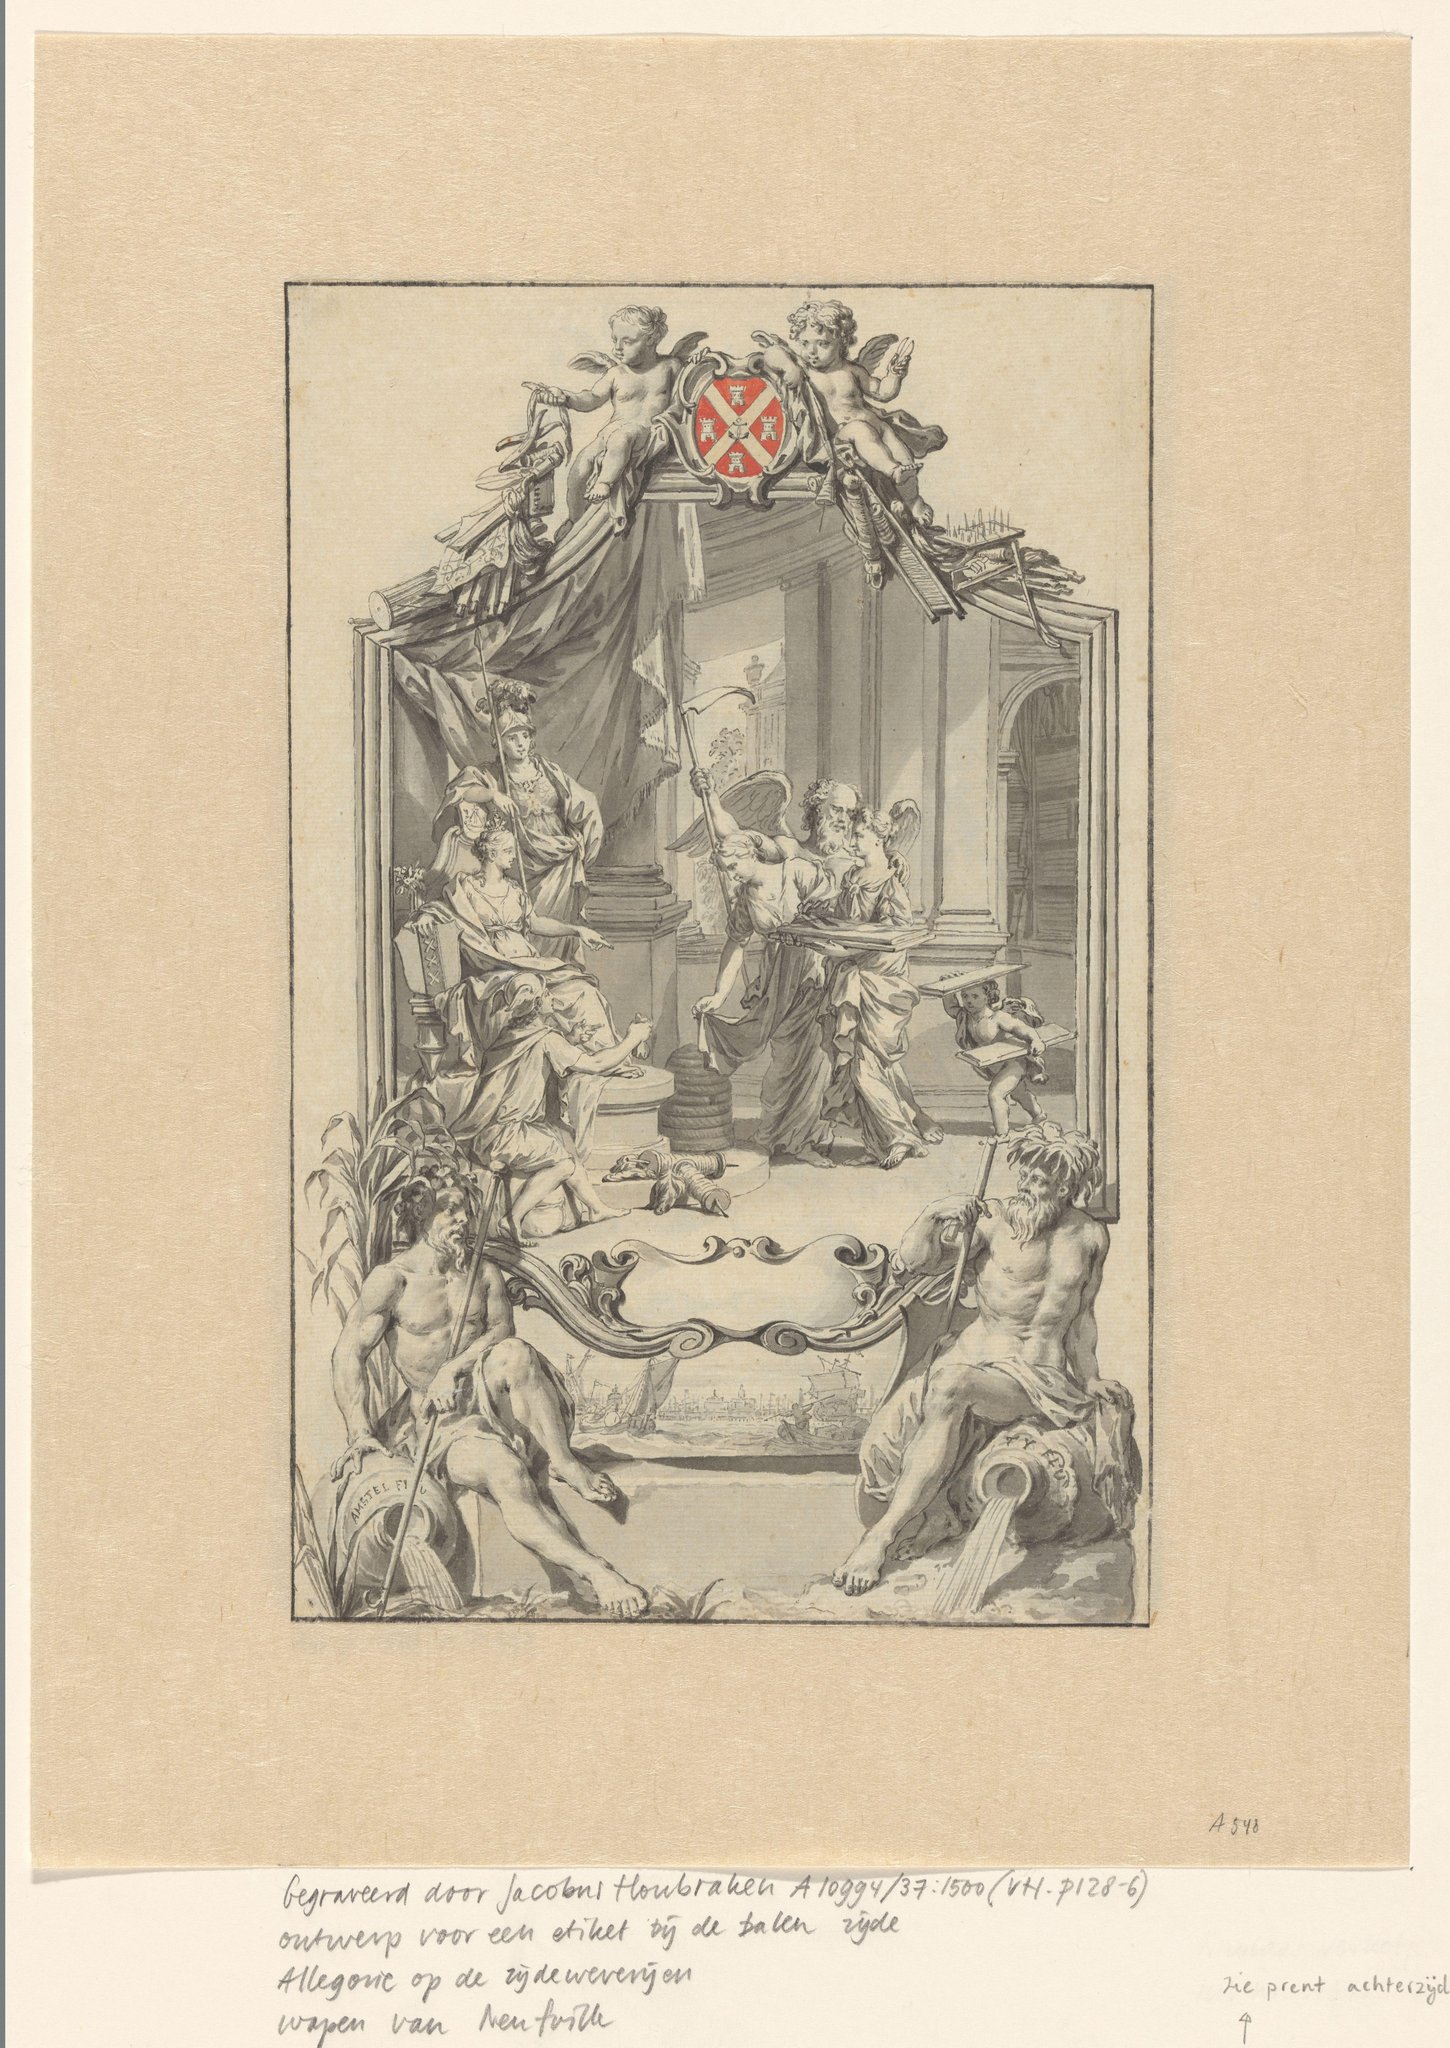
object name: drawing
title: Allegorie op de zijde-industrie in Amsterdam met de Stedenmaagd die balen zijde ontvangt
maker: nicolaas verkolje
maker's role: draughtsman, painter, print maker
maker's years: 1673-1746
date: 1720-1725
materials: paper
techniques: brush, pen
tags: armorial bearing, heraldry, silk (material ~ textile industry)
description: Allegorie op de zijde-industrie in Amsterdam: de Stedenmaagd, geflankeerd door Wijsheid en Koophandel, ontvangt balen zijde. In de cartouche, onder: de stroomgoden van Amstel en IJ; boven: putti met het wapen van de familie De Neufville en attributen van de zijdeweverij. Ontwerp voor een etiket.